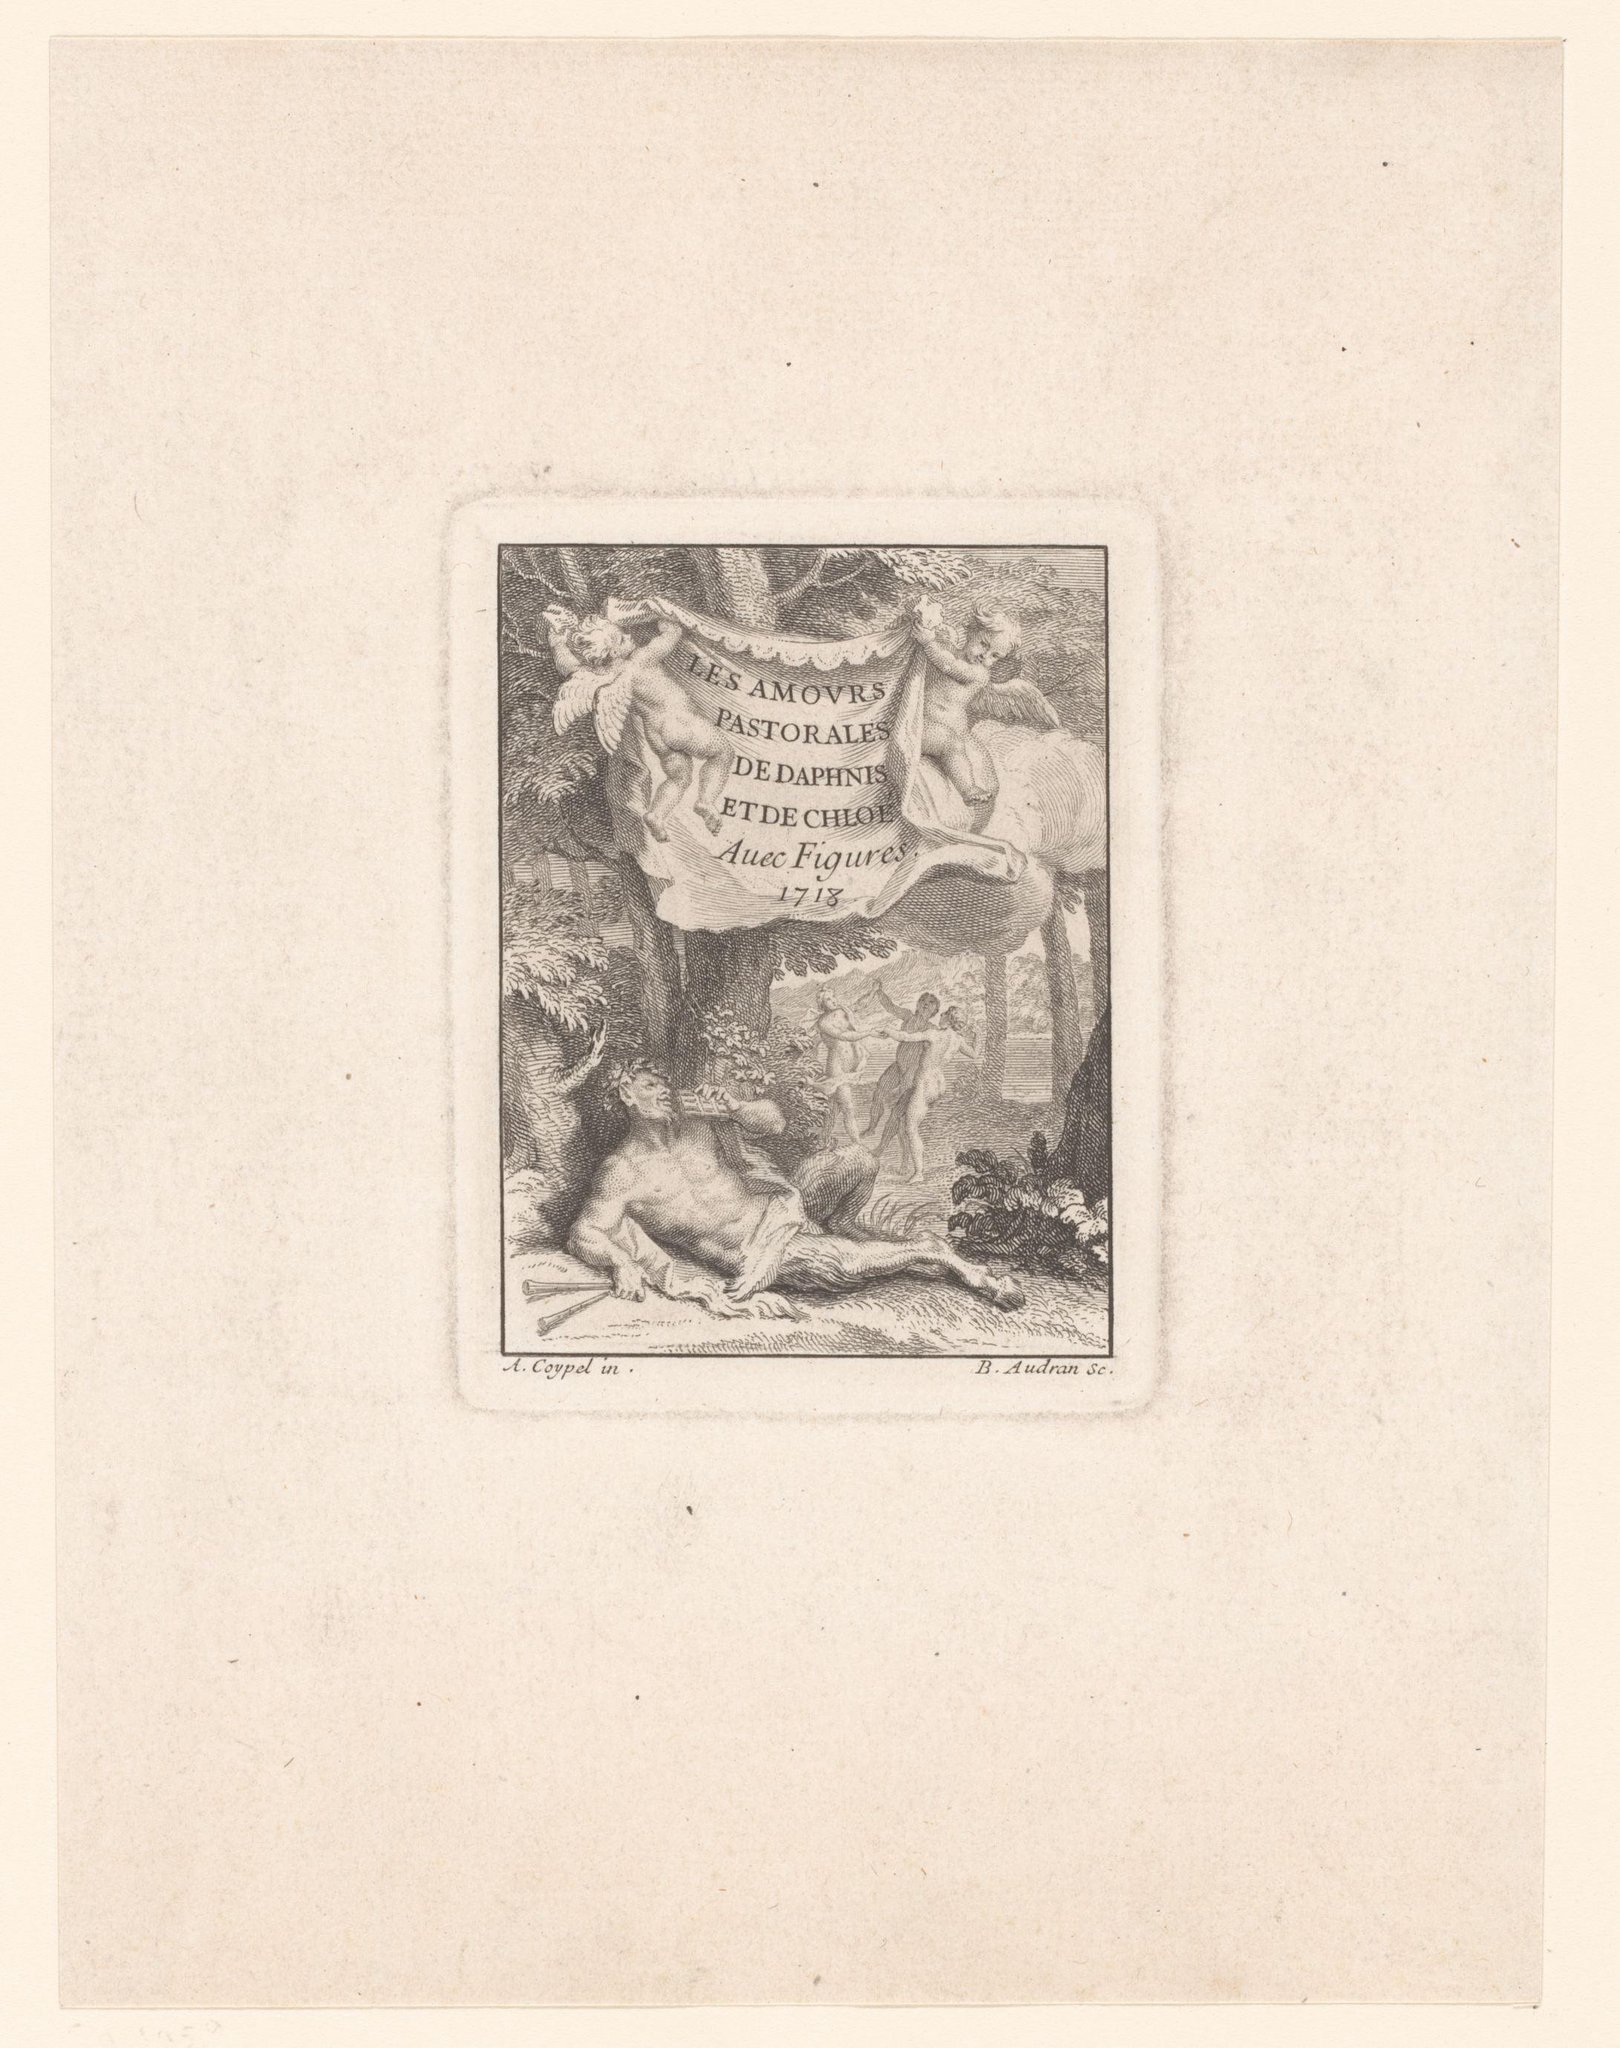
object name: print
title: Pan en de drie gratiën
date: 1718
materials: paper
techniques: etching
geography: paris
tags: (story of) pan, daphnis (in greek mythology a shepherd who invented pastoral poetry, chloe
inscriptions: collector's mark: Lugt 2760, collector's mark: Lugt 2228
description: Op de voorgrond ligt Pan tegen een boom. Boven hem zweven twee engelen met een doek waarop de titel en datum genoteerd staan. Op de achtergrond dansen de drie gratiën.